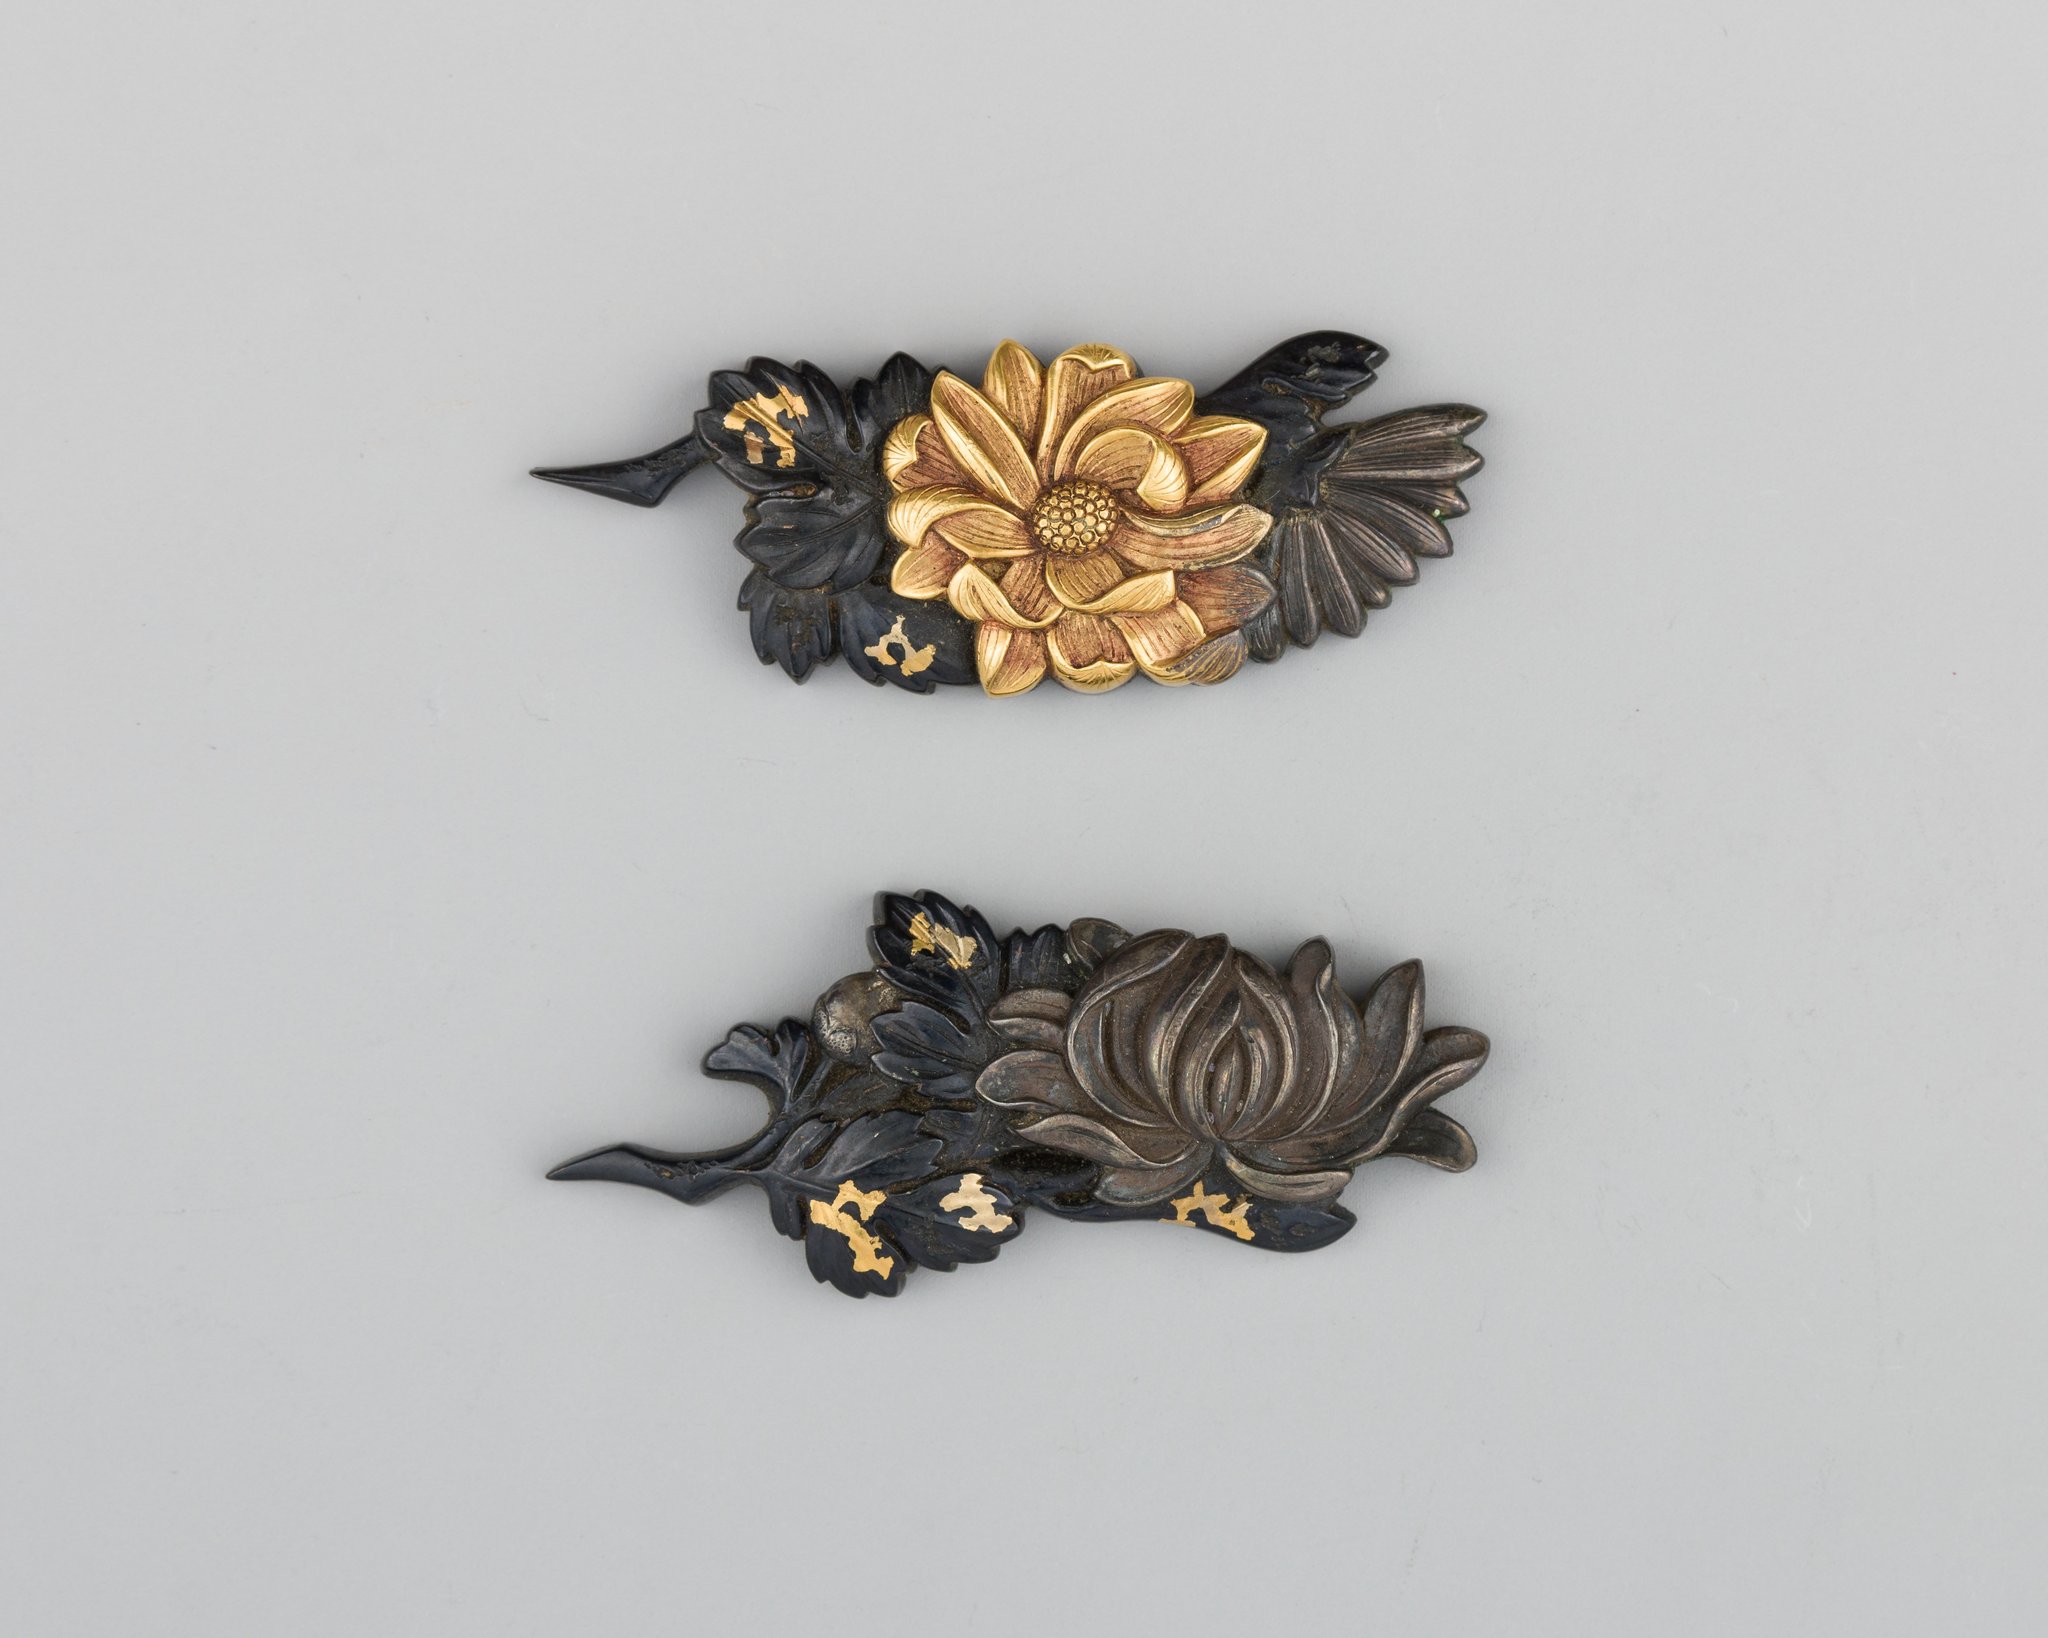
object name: pair of sword grip ornament menuki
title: Pair of Sword-Grip Ornaments (Menuki)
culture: japanese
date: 1615-1868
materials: alloy, copper, gold alloy, gold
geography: japan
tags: flowers